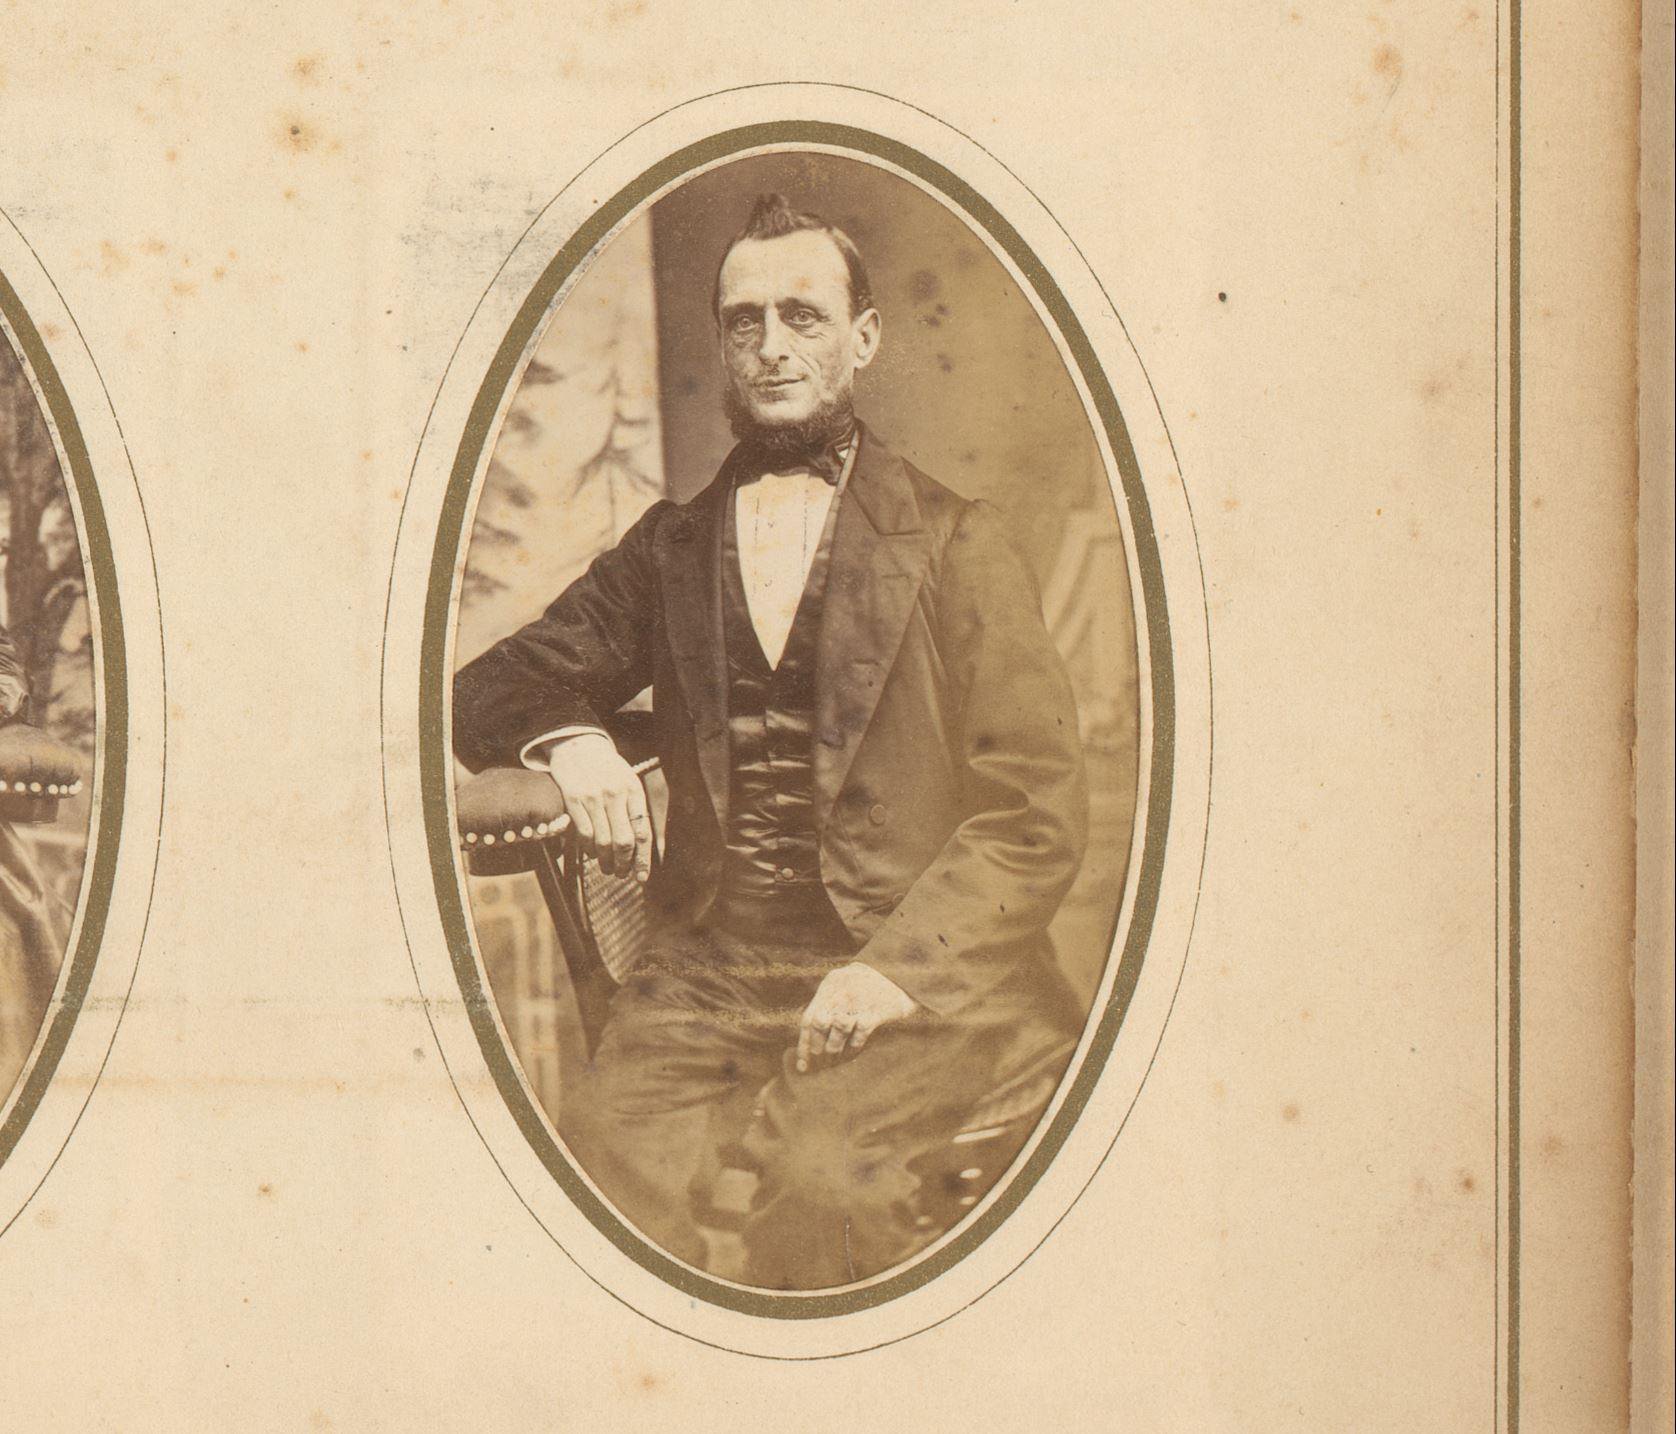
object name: album leaf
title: Portret van een zittende man met ringbaard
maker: coenraad cornelis roskam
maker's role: fotograaf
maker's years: 1829-1892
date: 1870-1892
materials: cardboard, photographic support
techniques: albumen print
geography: amsterdam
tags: sitting figure, historical persons, beard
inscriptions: inscription: ‘Photographisch/ ATELIER/ van/ C. C. Roskam/ UTRECHTSCHE/ STRAAT./ tusschen de Keizersgr en Kerkstr/ Z. 855,/ Amsterdam.’